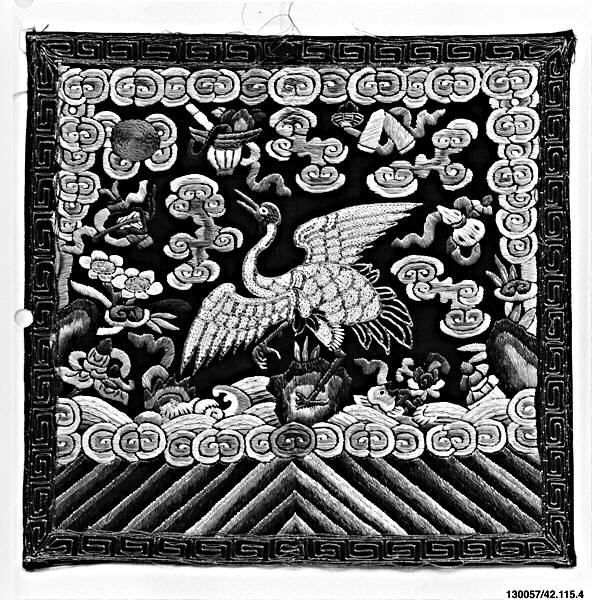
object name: rank badge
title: Rank Badge with White Crane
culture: chinese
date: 1801-1833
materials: silk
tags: cranes